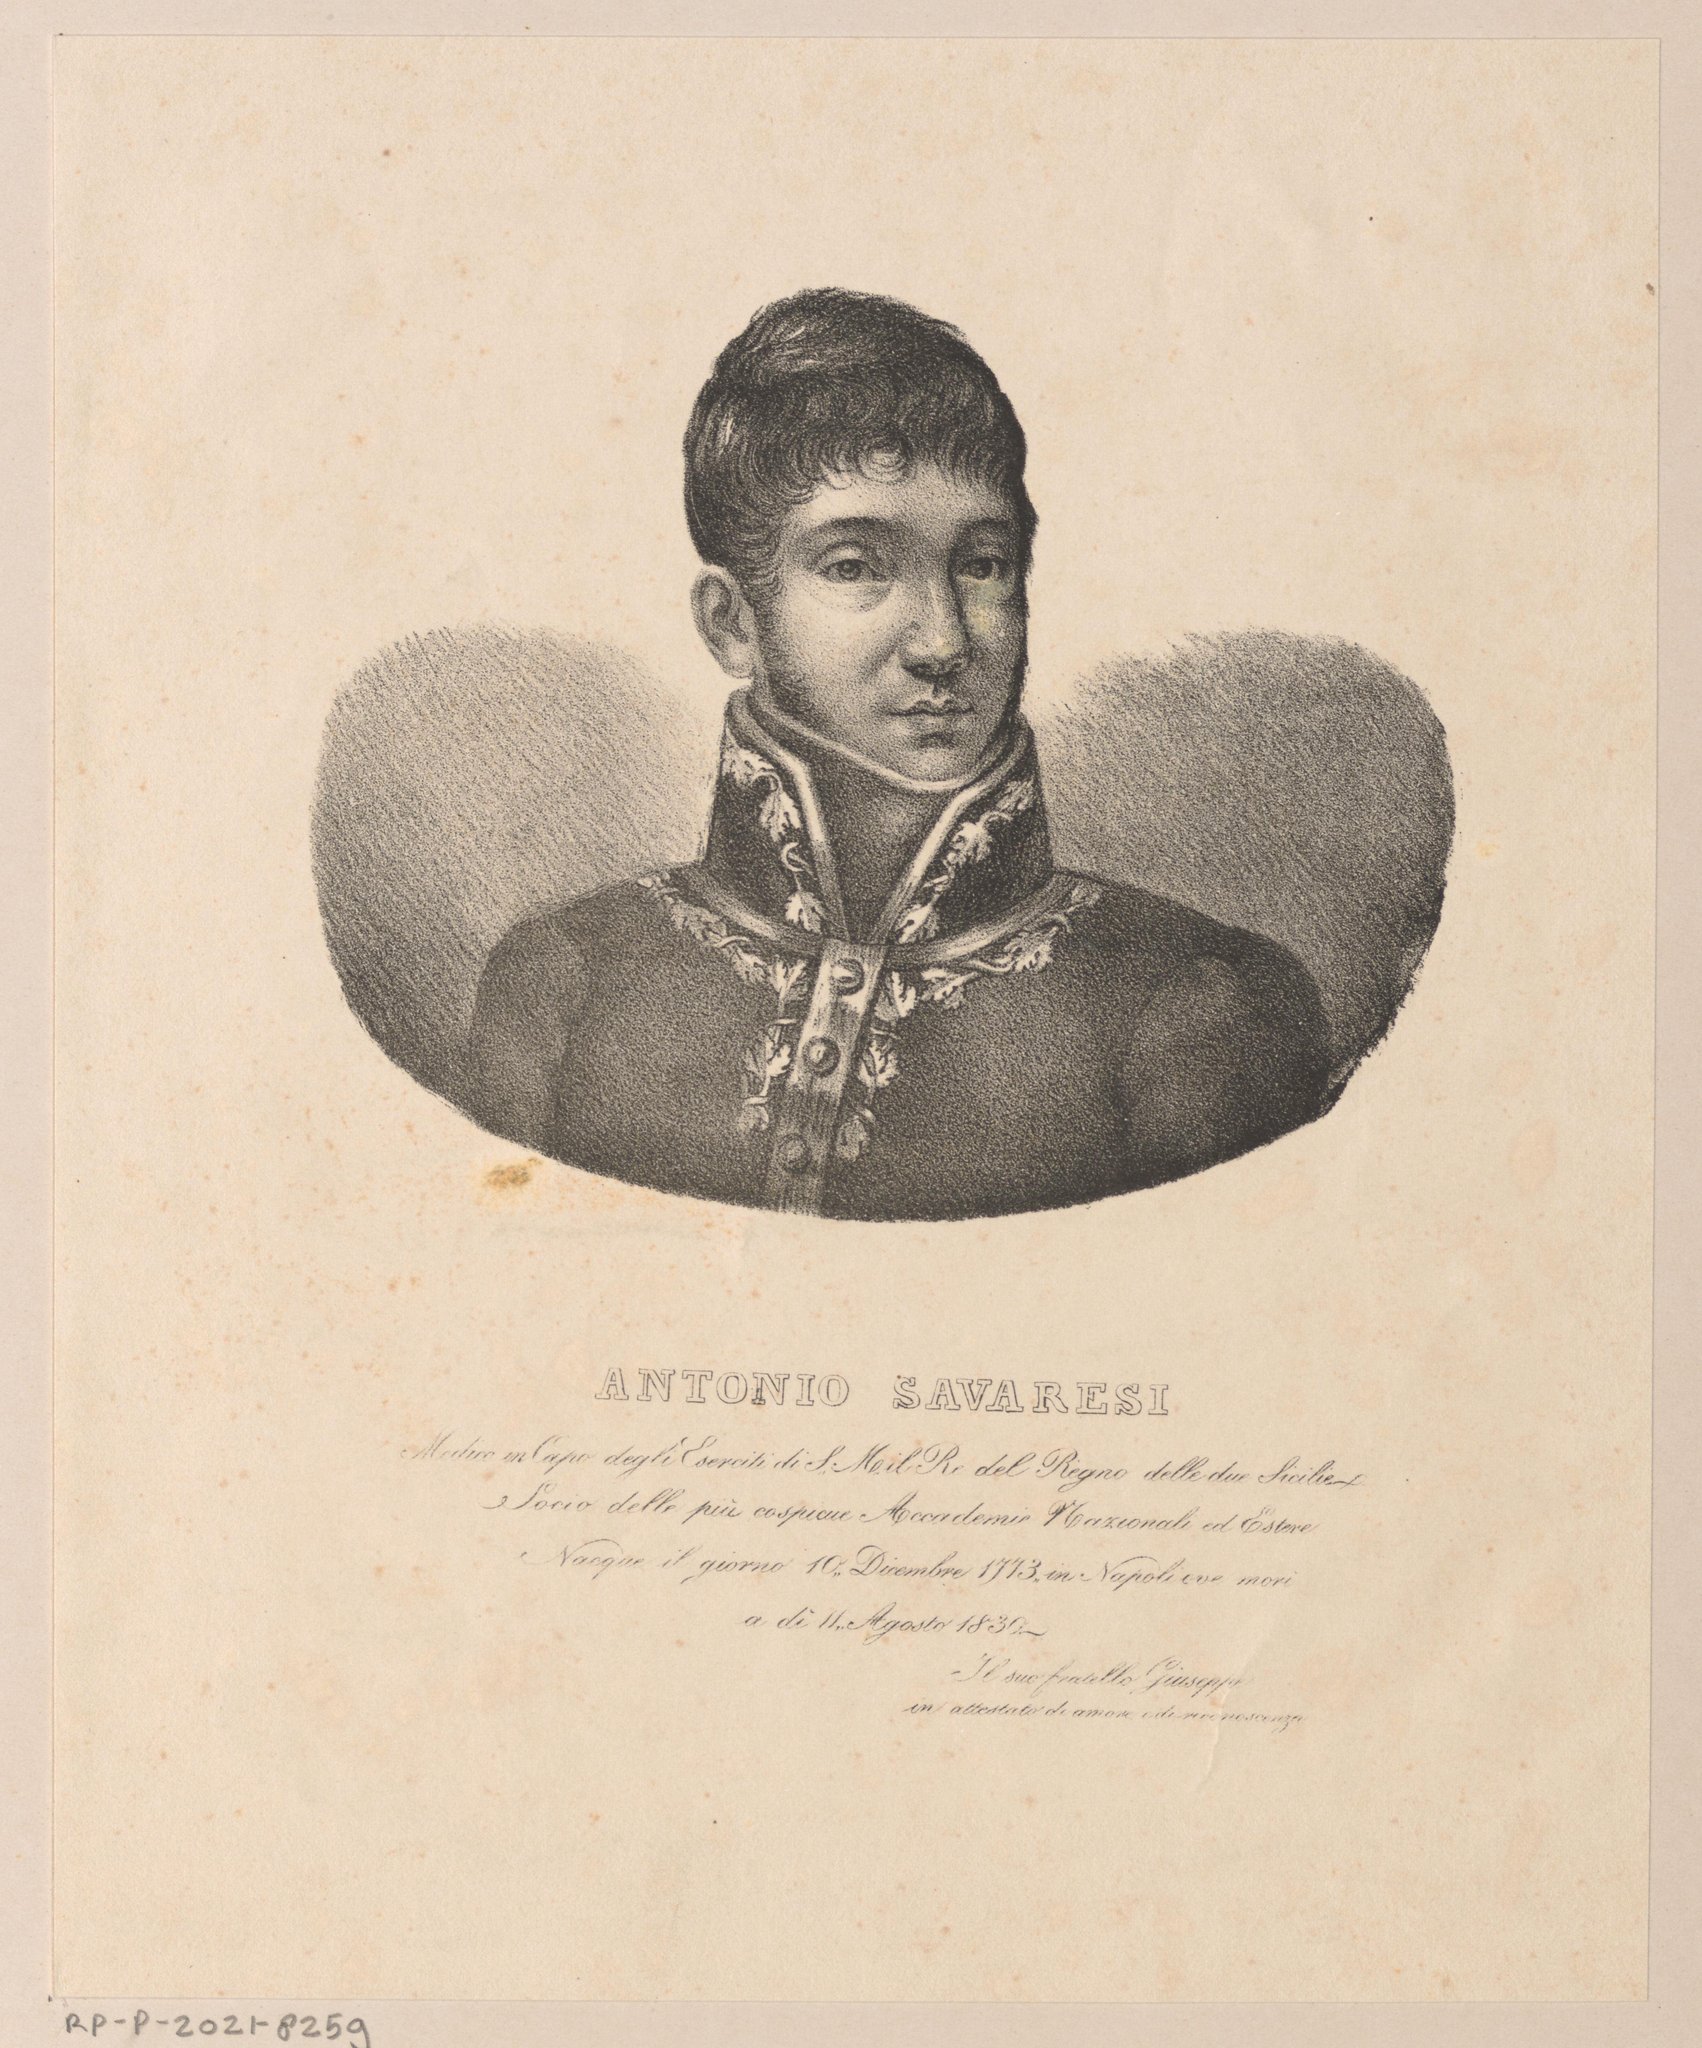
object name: print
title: Portret van Antonio Savaresi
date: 1830-1850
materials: paper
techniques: lithograph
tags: historical persons, physician, doctor